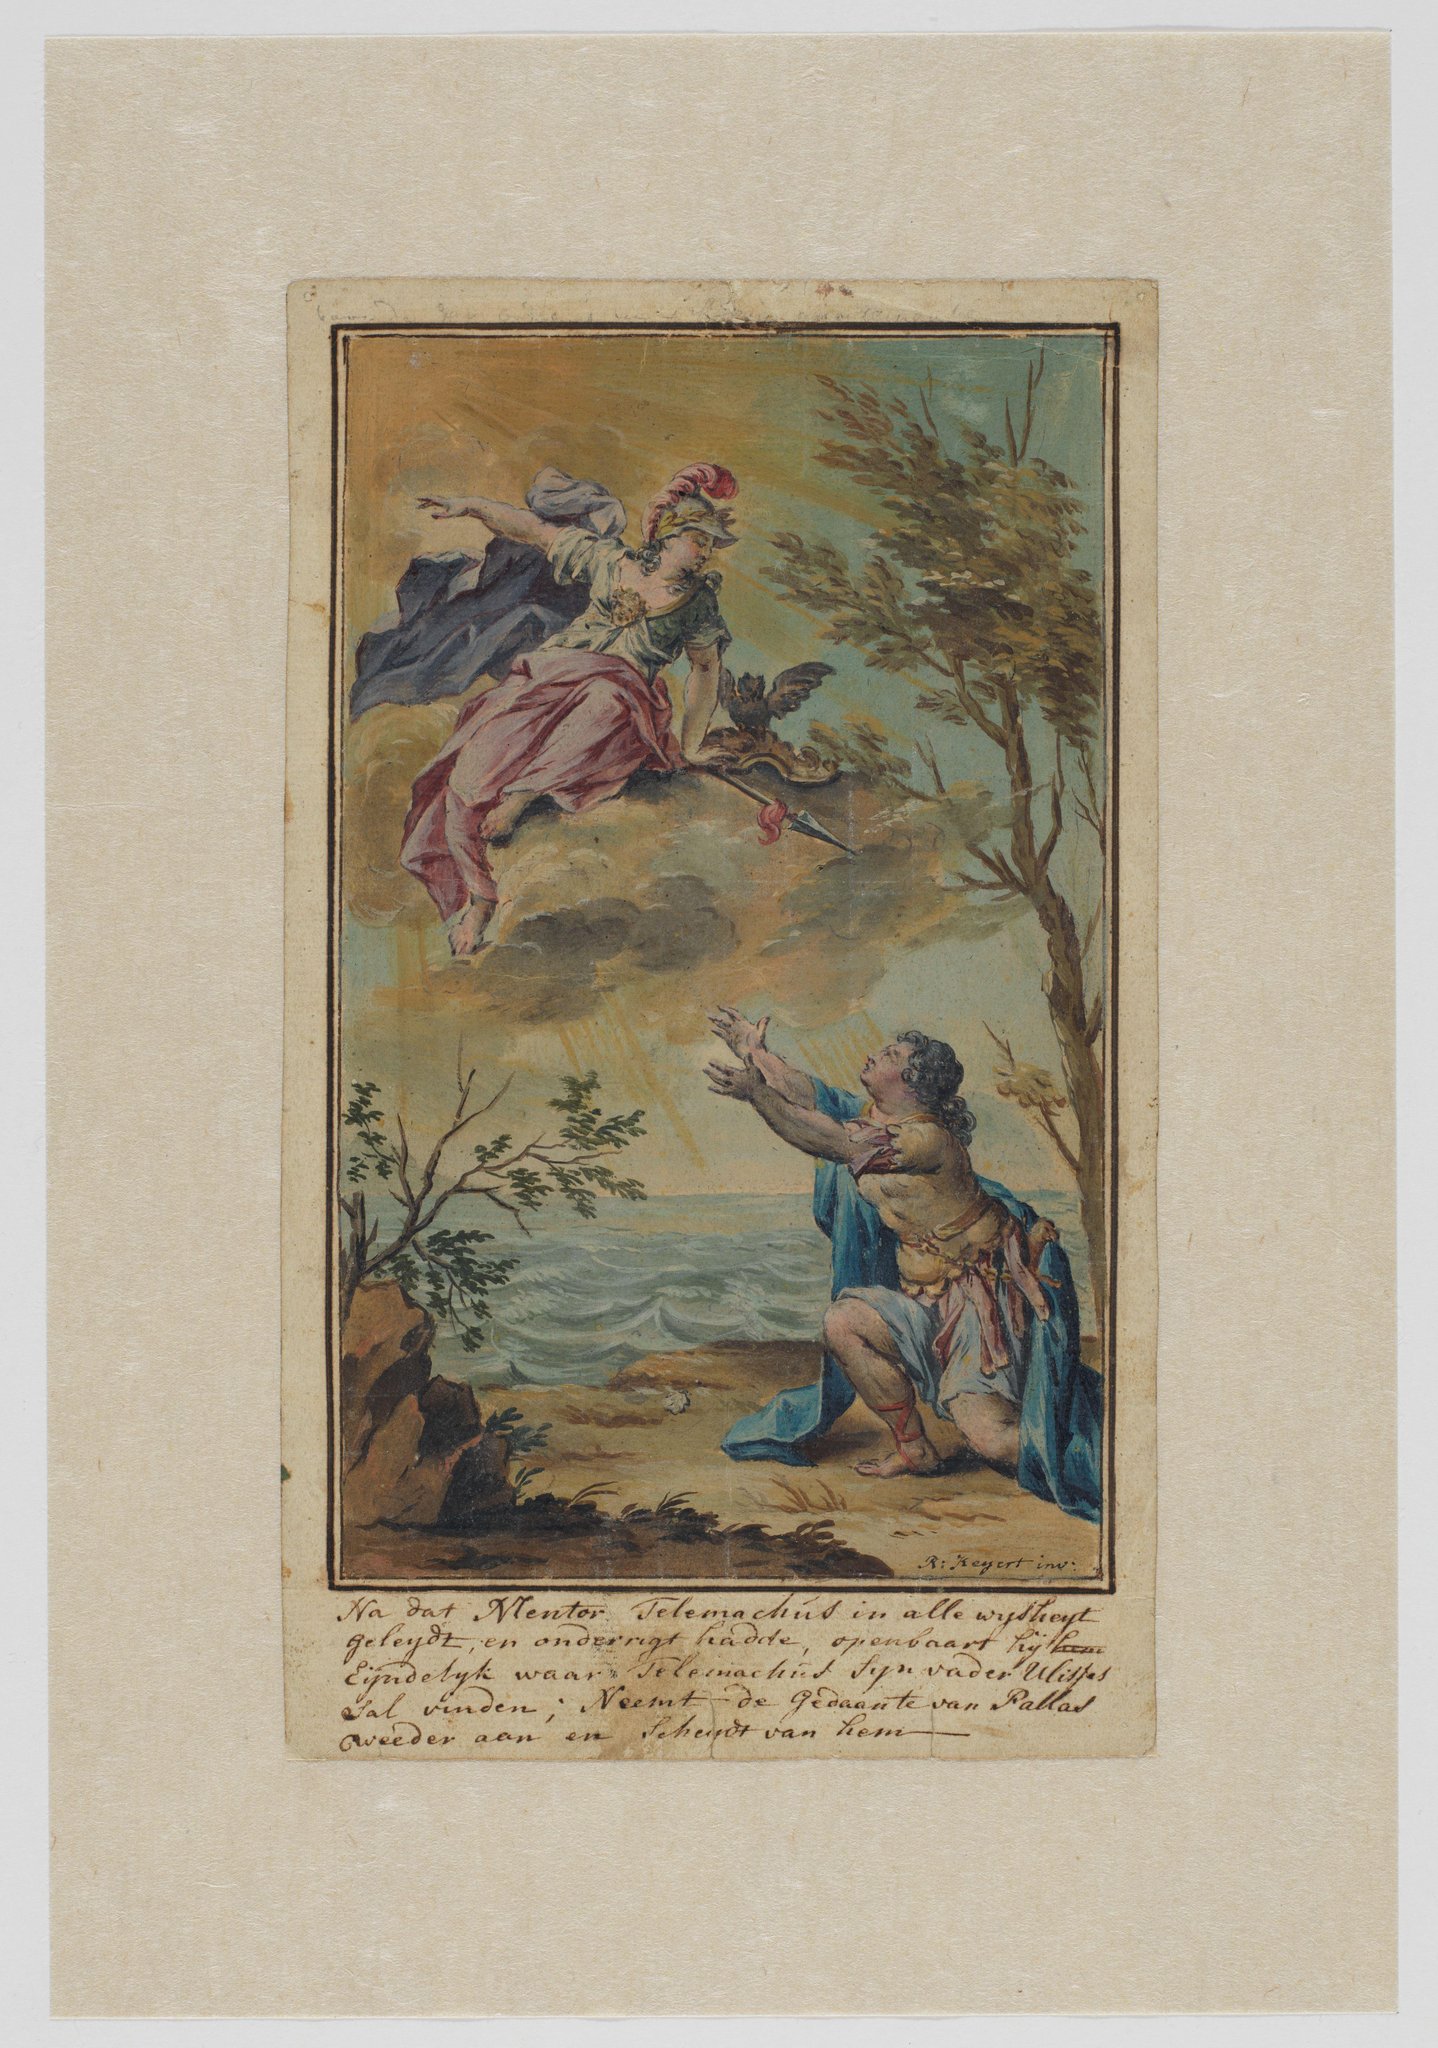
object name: watercolor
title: Mentor neemt afscheid van Telemachus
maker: rienk keyert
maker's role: draughtsman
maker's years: 1709-1775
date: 1719-1775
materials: ink, paper, watercolor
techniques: brush, pen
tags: (story of) telemachus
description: Mentor neemt afscheid van Telemachus, vertelt hem waar hij zijn vader Odysseus zal vinden en neemt de gedaante van Pallas Athene weer aan. Onderaan in de marge beschrijving van de voorstelling. Ontwerp voor een behangschildering.